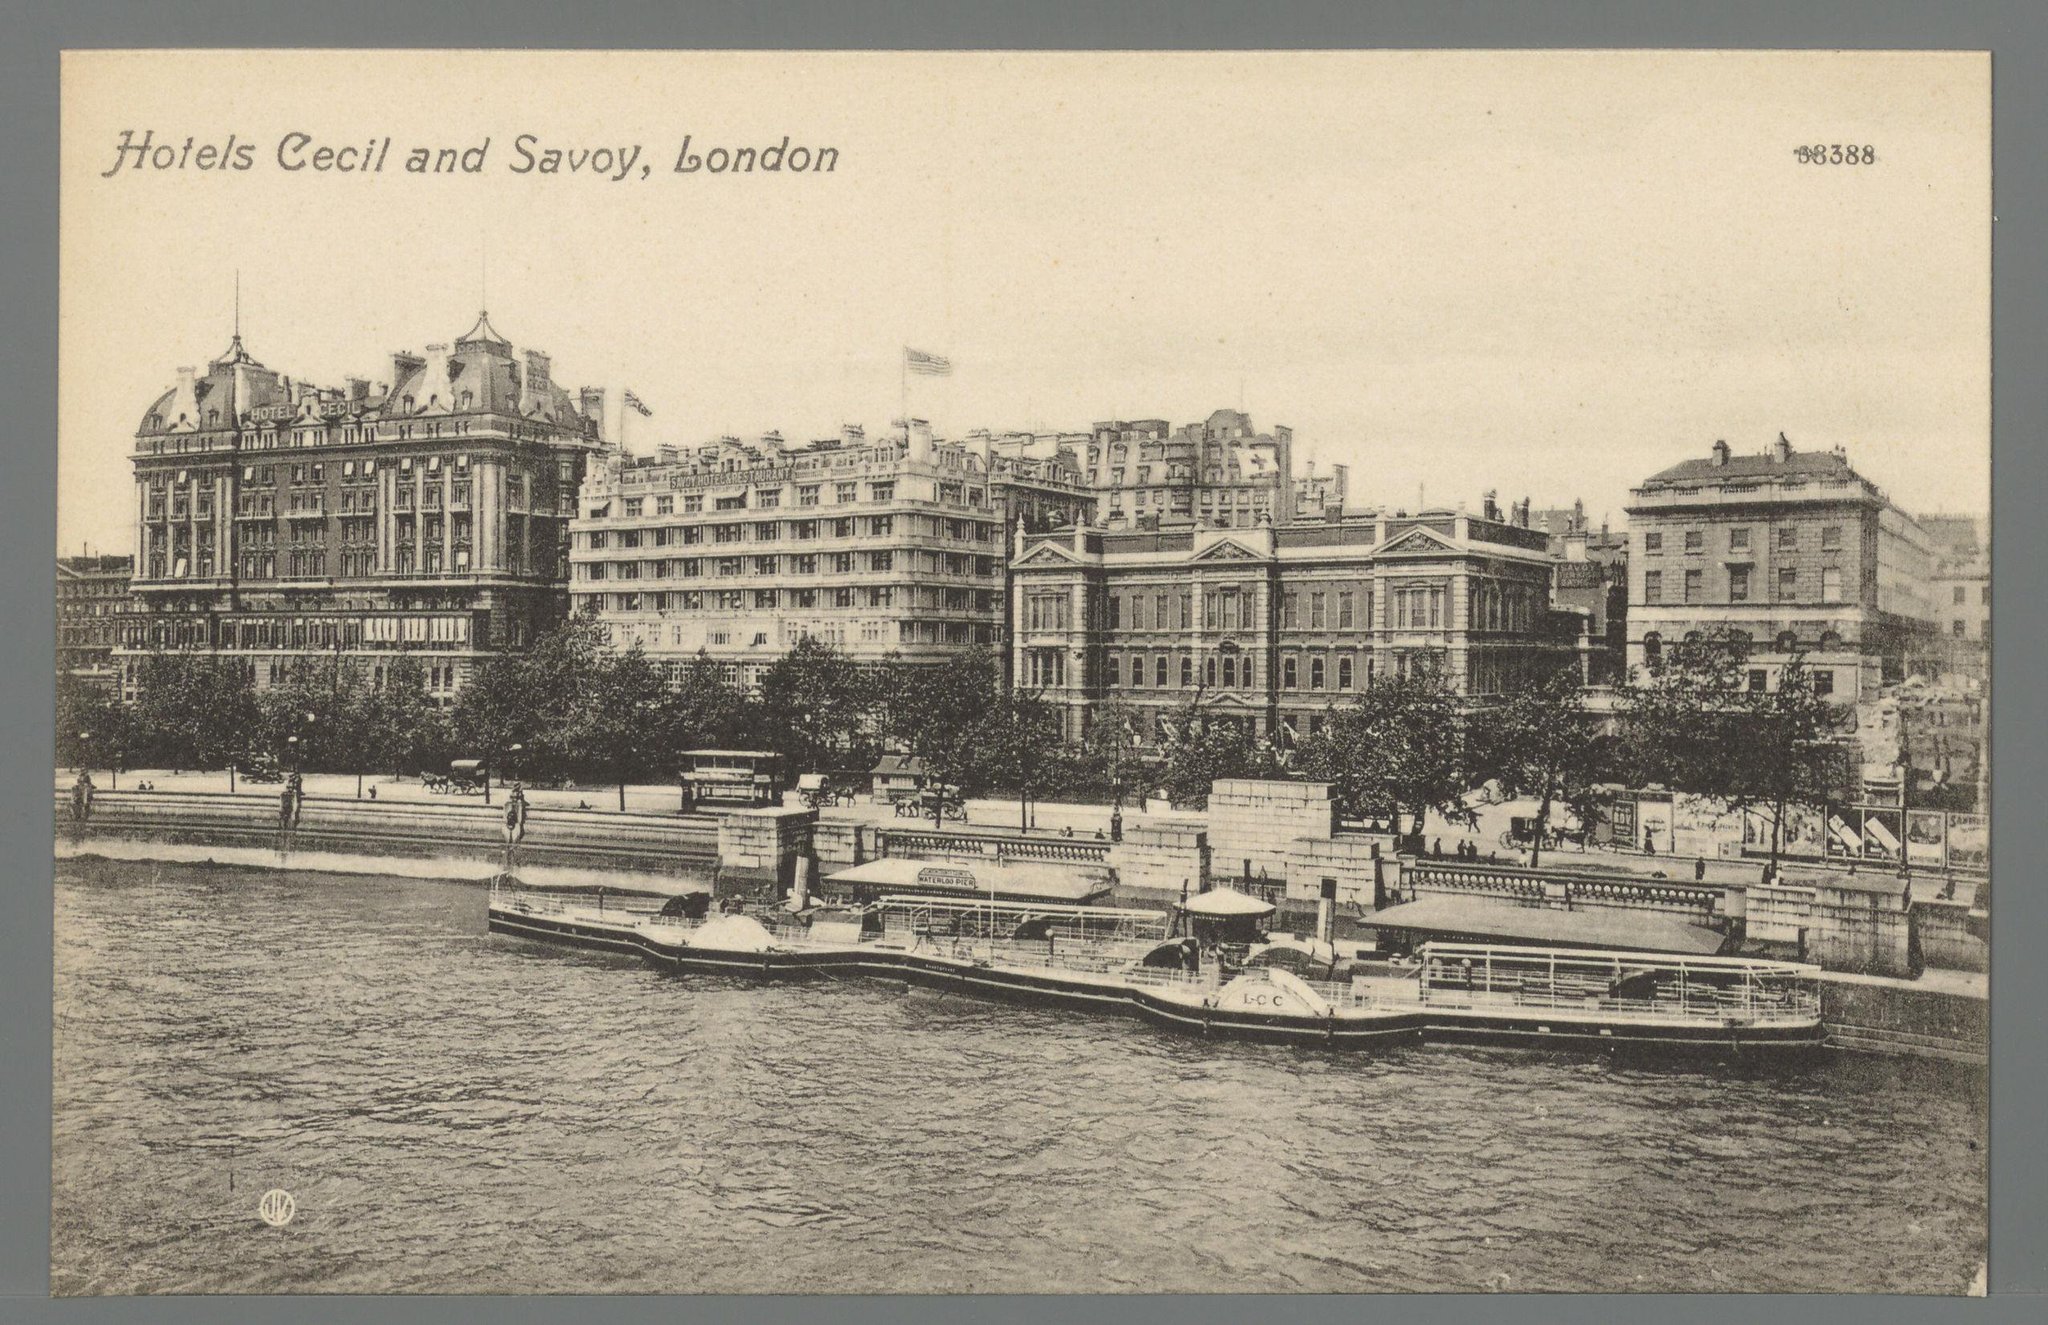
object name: photomechanical print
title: Hotels Cecil and Savoy, London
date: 1902-1930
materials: cardboard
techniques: photograph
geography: dundee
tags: canals, waters (in city), hotel, hostelry, inn, thames